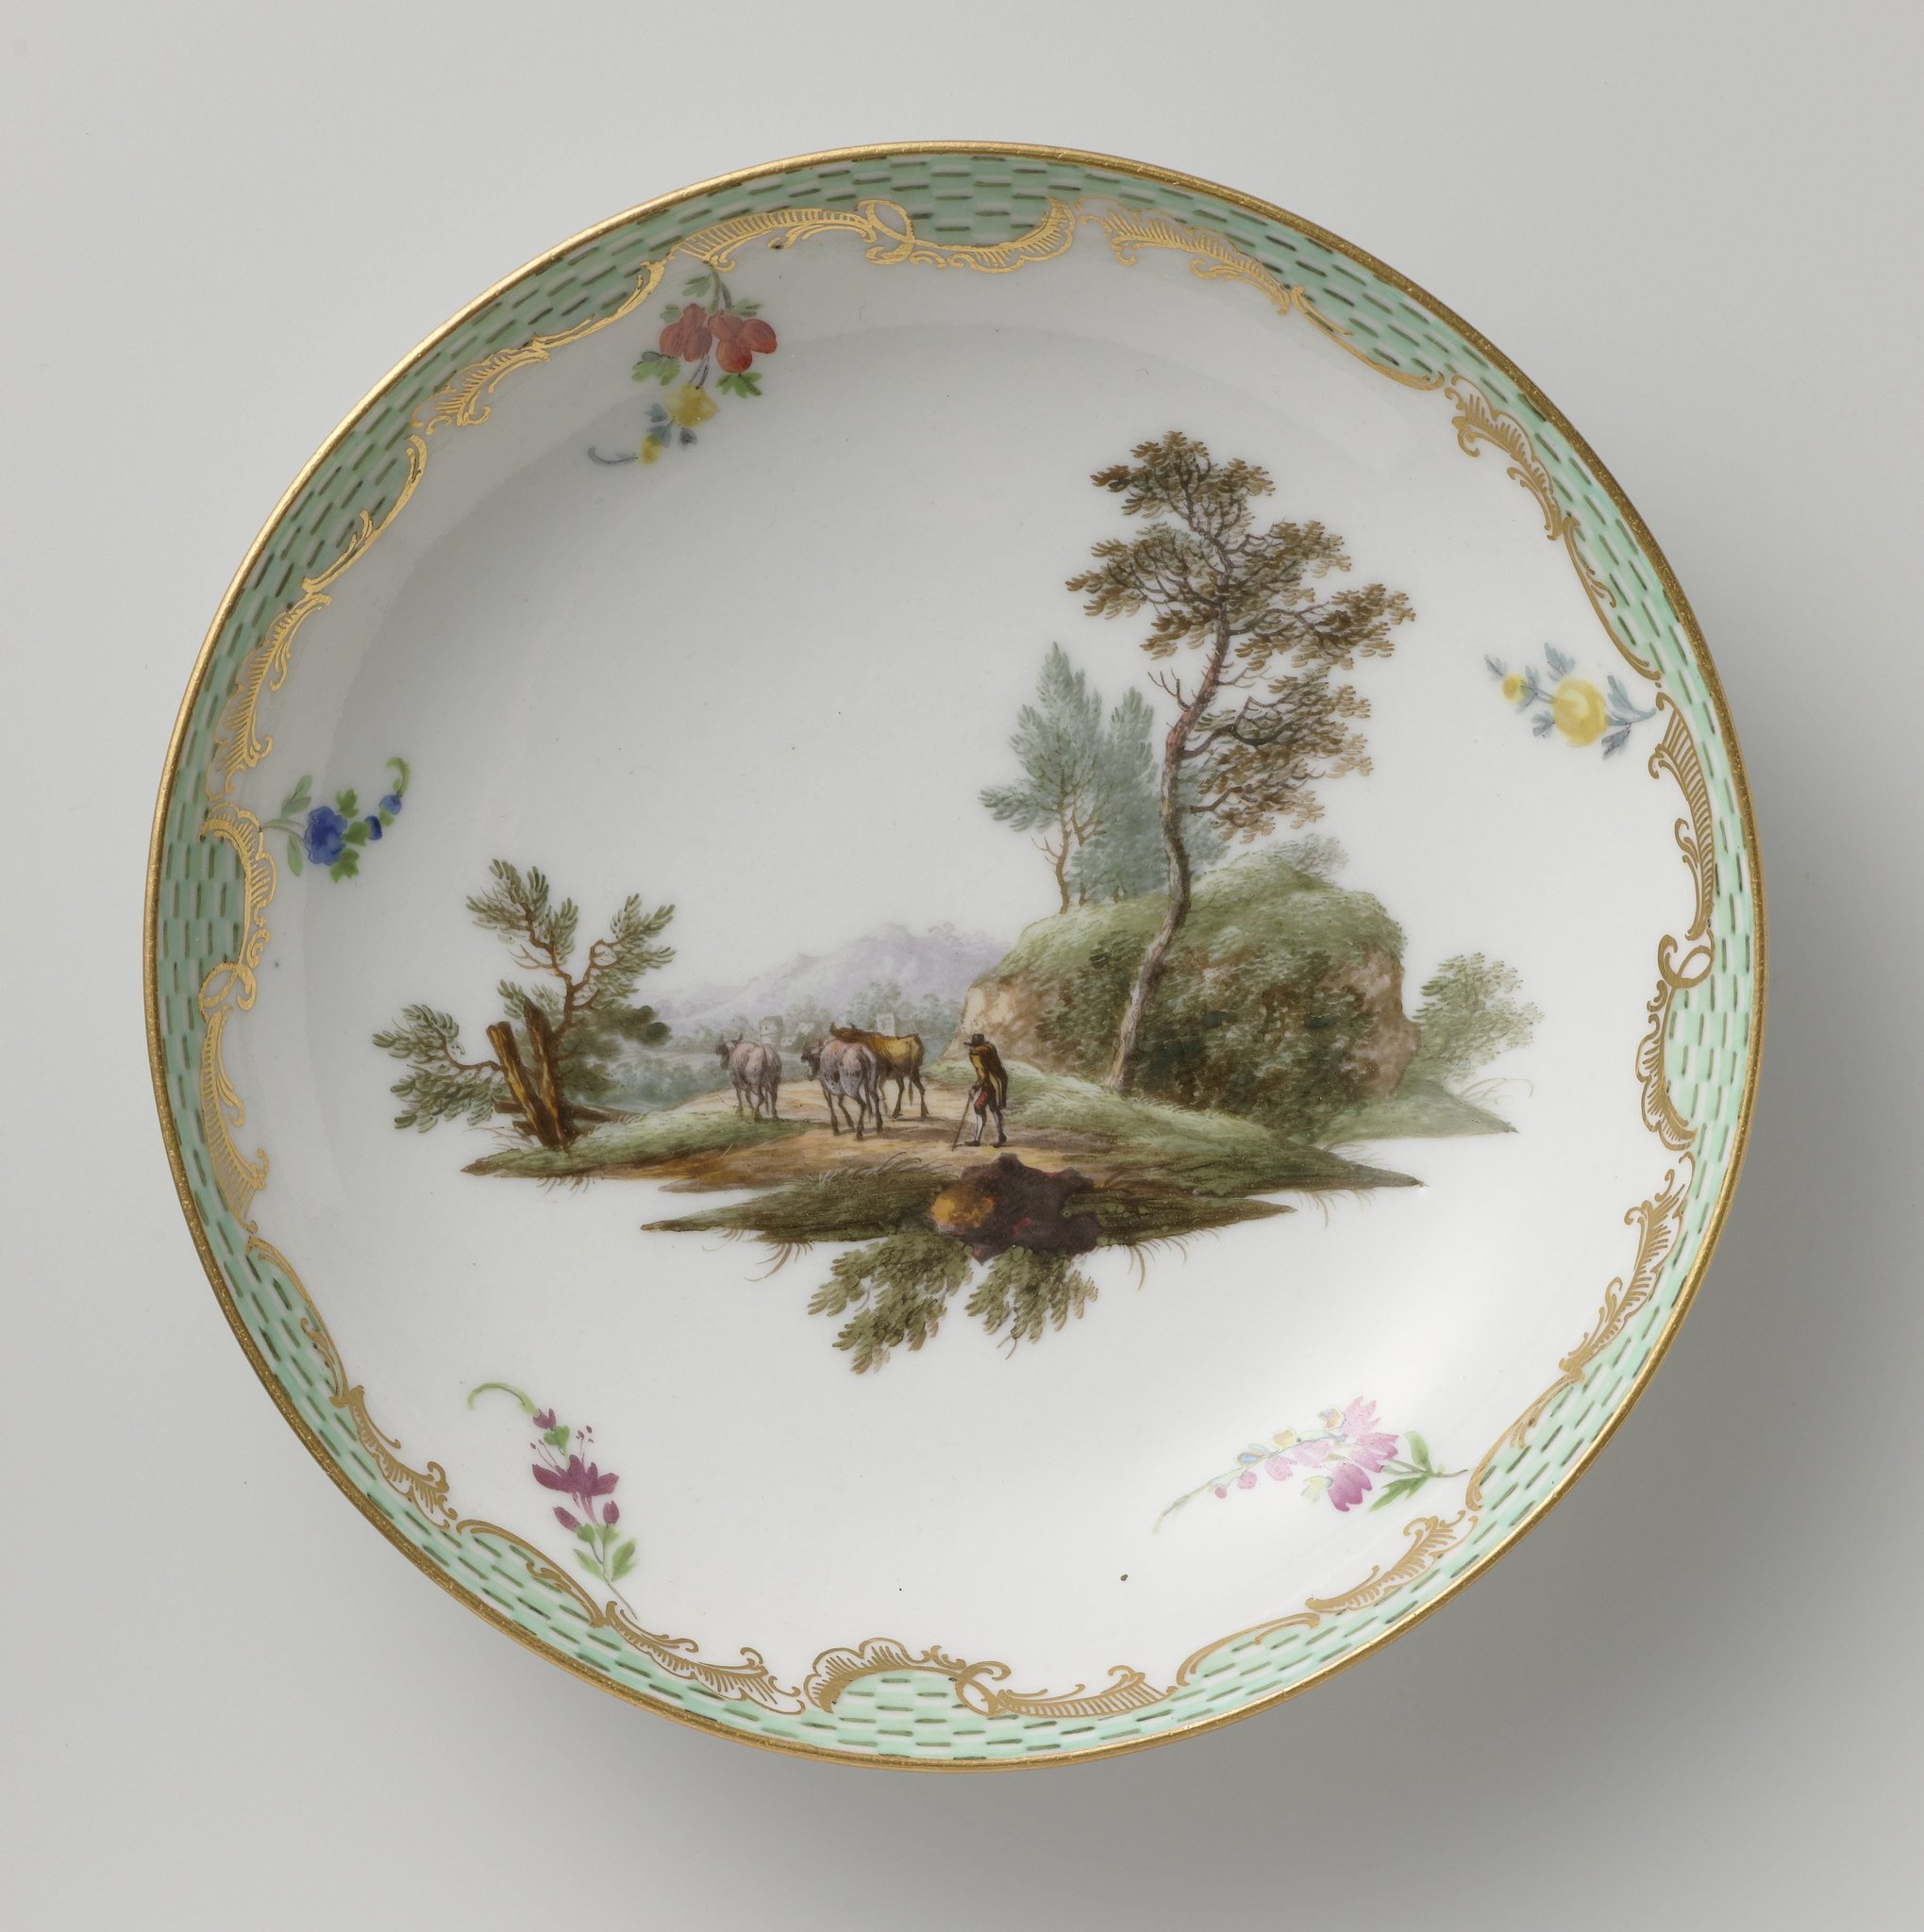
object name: platter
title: Schotel, veelkleurig beschilderd met een landschap met figuren.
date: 1777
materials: porcelain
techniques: painted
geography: meissen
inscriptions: mold mark: ‘5’, factory mark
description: Ronde schotel van beschilderd porselein. De schotel is beschilderd met landschappen waarin figuren en langs de rand een brede strook groen vlechtwerk. De schotel is gemerkt.